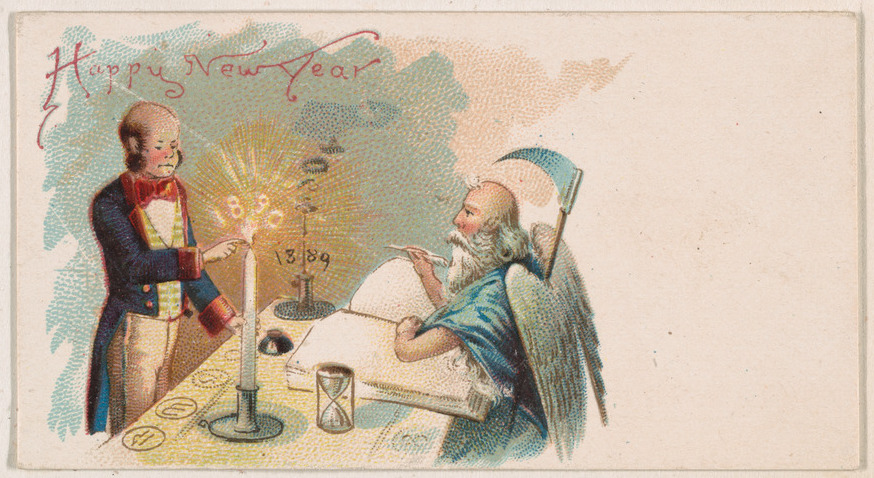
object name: print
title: Happy New Year 1890, from the New Years 1890 series (N227) issued by Kinney Bros.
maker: kinney brothers tobacco company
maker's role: publisher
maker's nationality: american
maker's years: 1869-2011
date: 1889-1890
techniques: color lithograph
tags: men